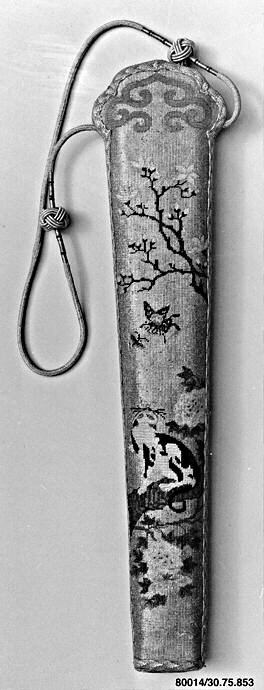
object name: fan holder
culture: chinese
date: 1701-1900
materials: metal thread, silk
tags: cats,butterflies